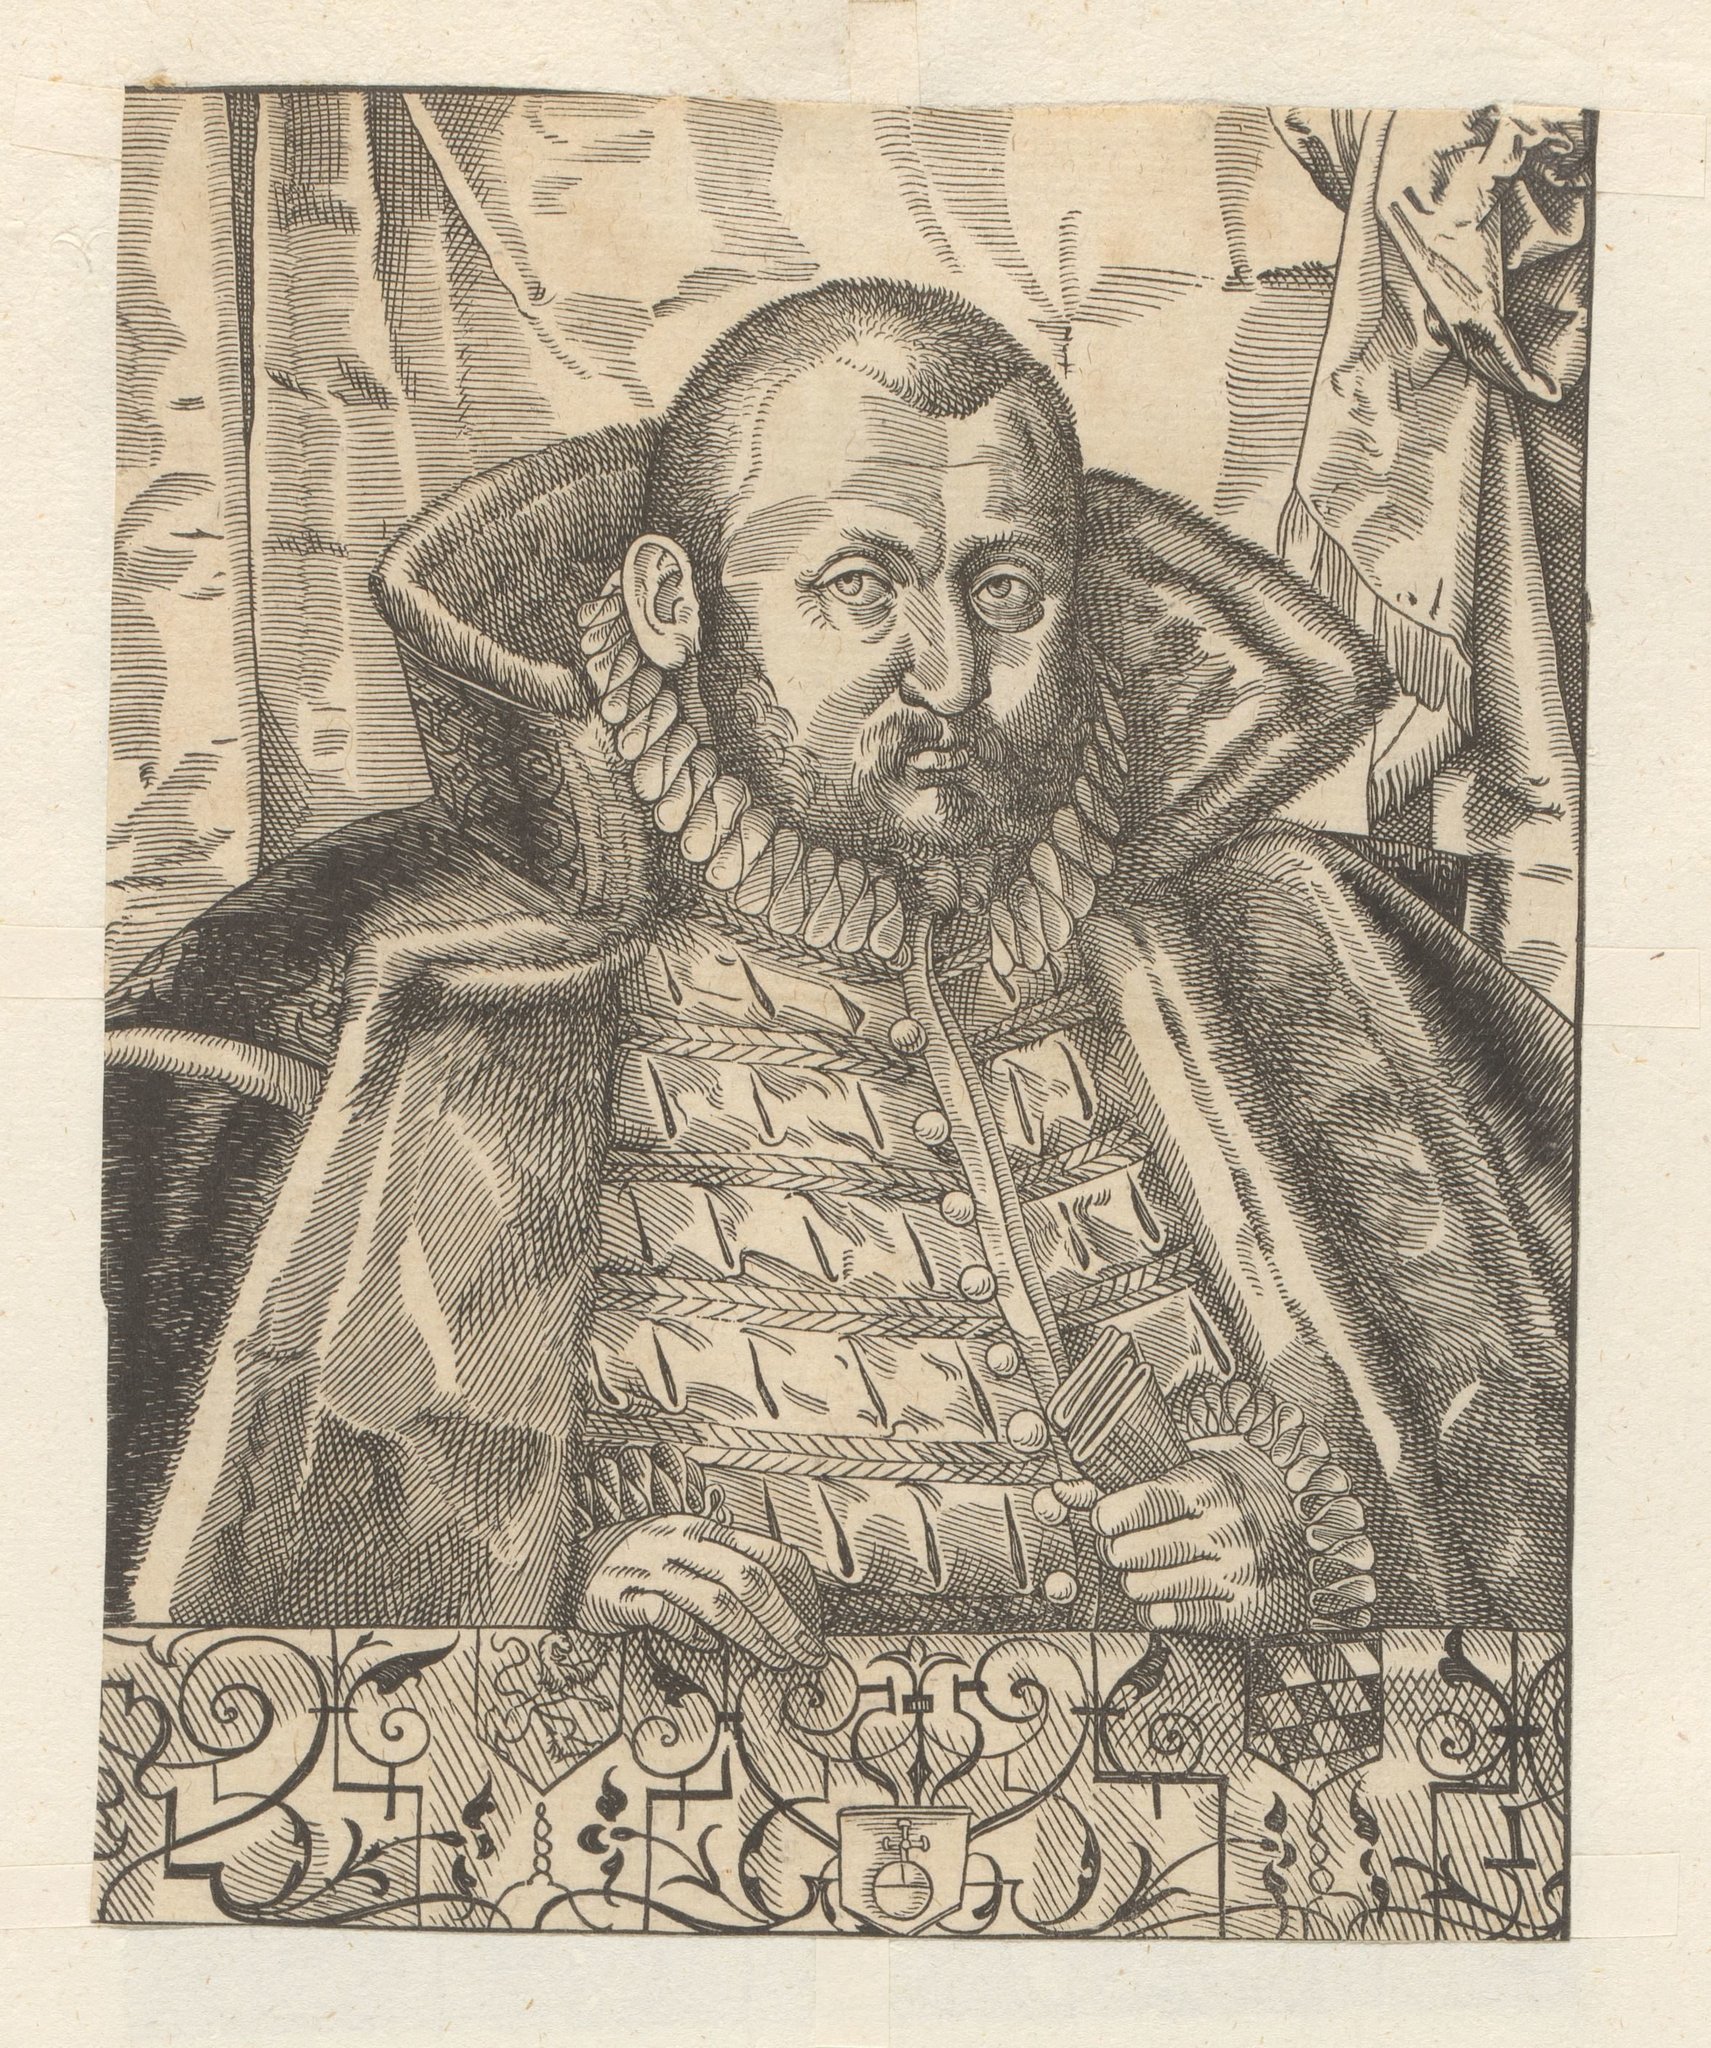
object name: print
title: Portret van Filips Lodewijk van Palts-Neuburg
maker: Anonymous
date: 1557-1615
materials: paper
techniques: woodcut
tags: earl, historical persons